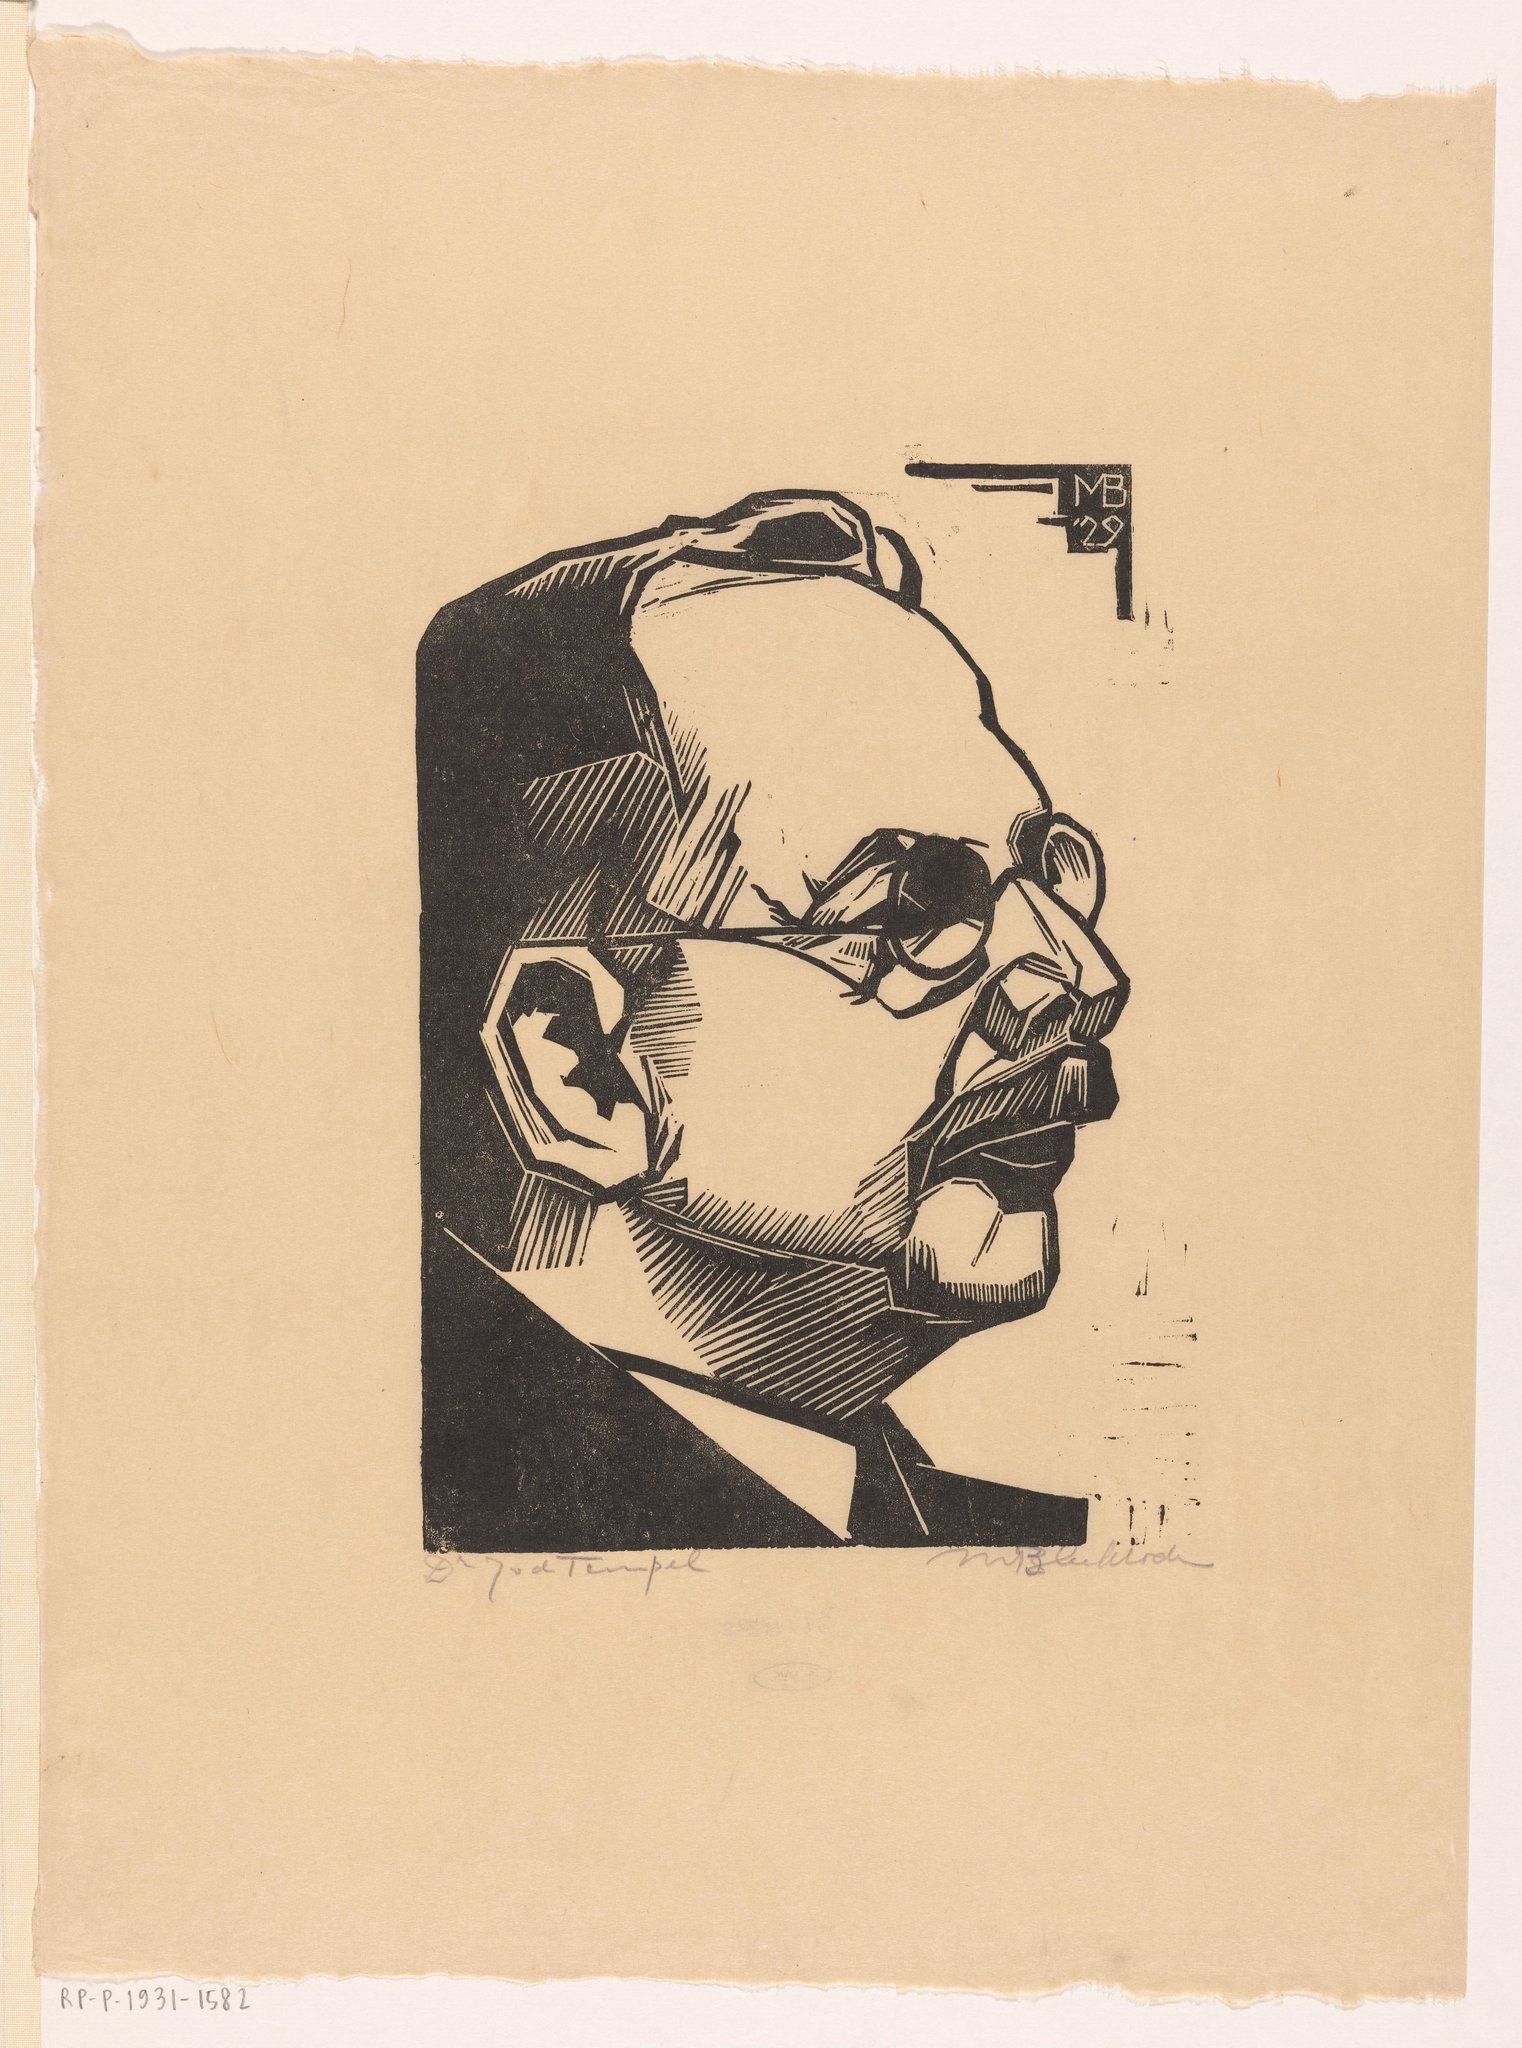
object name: print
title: Portret van Jan van den Tempel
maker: meijer bleekrode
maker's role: draughtsman, painter, print maker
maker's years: 1896-1943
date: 1929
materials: paper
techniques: woodcut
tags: politician, politician, e.g. party leader, historical persons (portraits and scenes from the life)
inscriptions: collector's mark: Lugt 2228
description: Portret van SDAP-Tweede Kamerlid Jan van den Tempel.